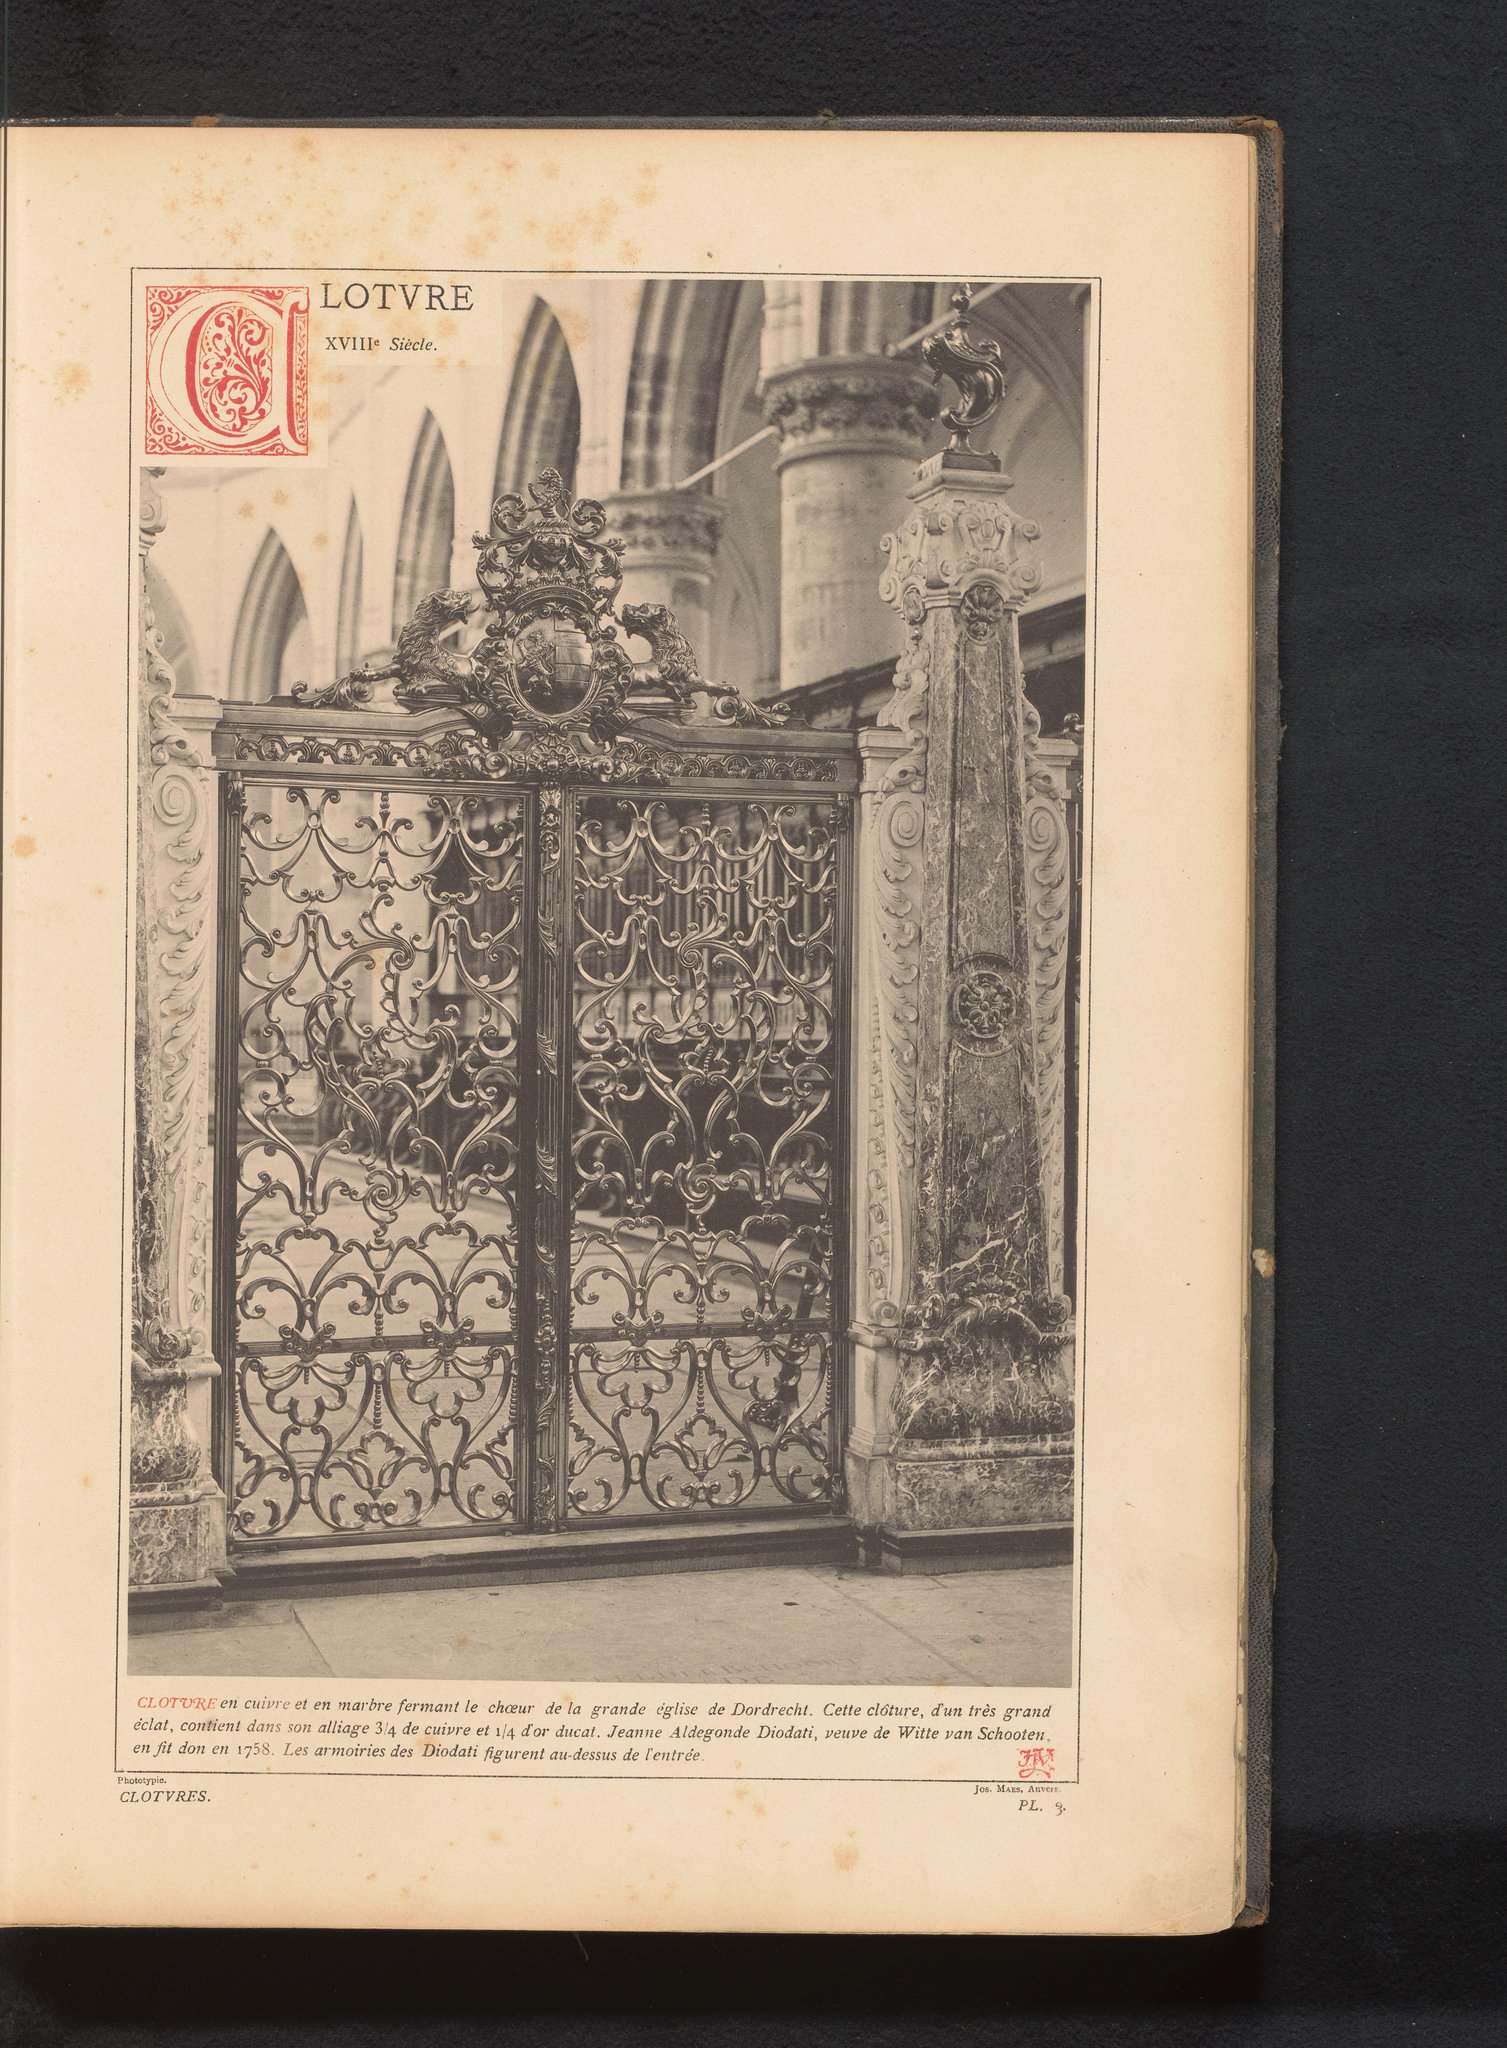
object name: page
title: Cloture, XVIIIe Siècle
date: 1881-1889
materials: paper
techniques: photograph, photolithography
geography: dordrecht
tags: interior of church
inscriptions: inscription: ‘CLOTURE en cuivre (...)’, inscription: ‘COTURES. PL. 3.’, monogram: ‘JJvY’